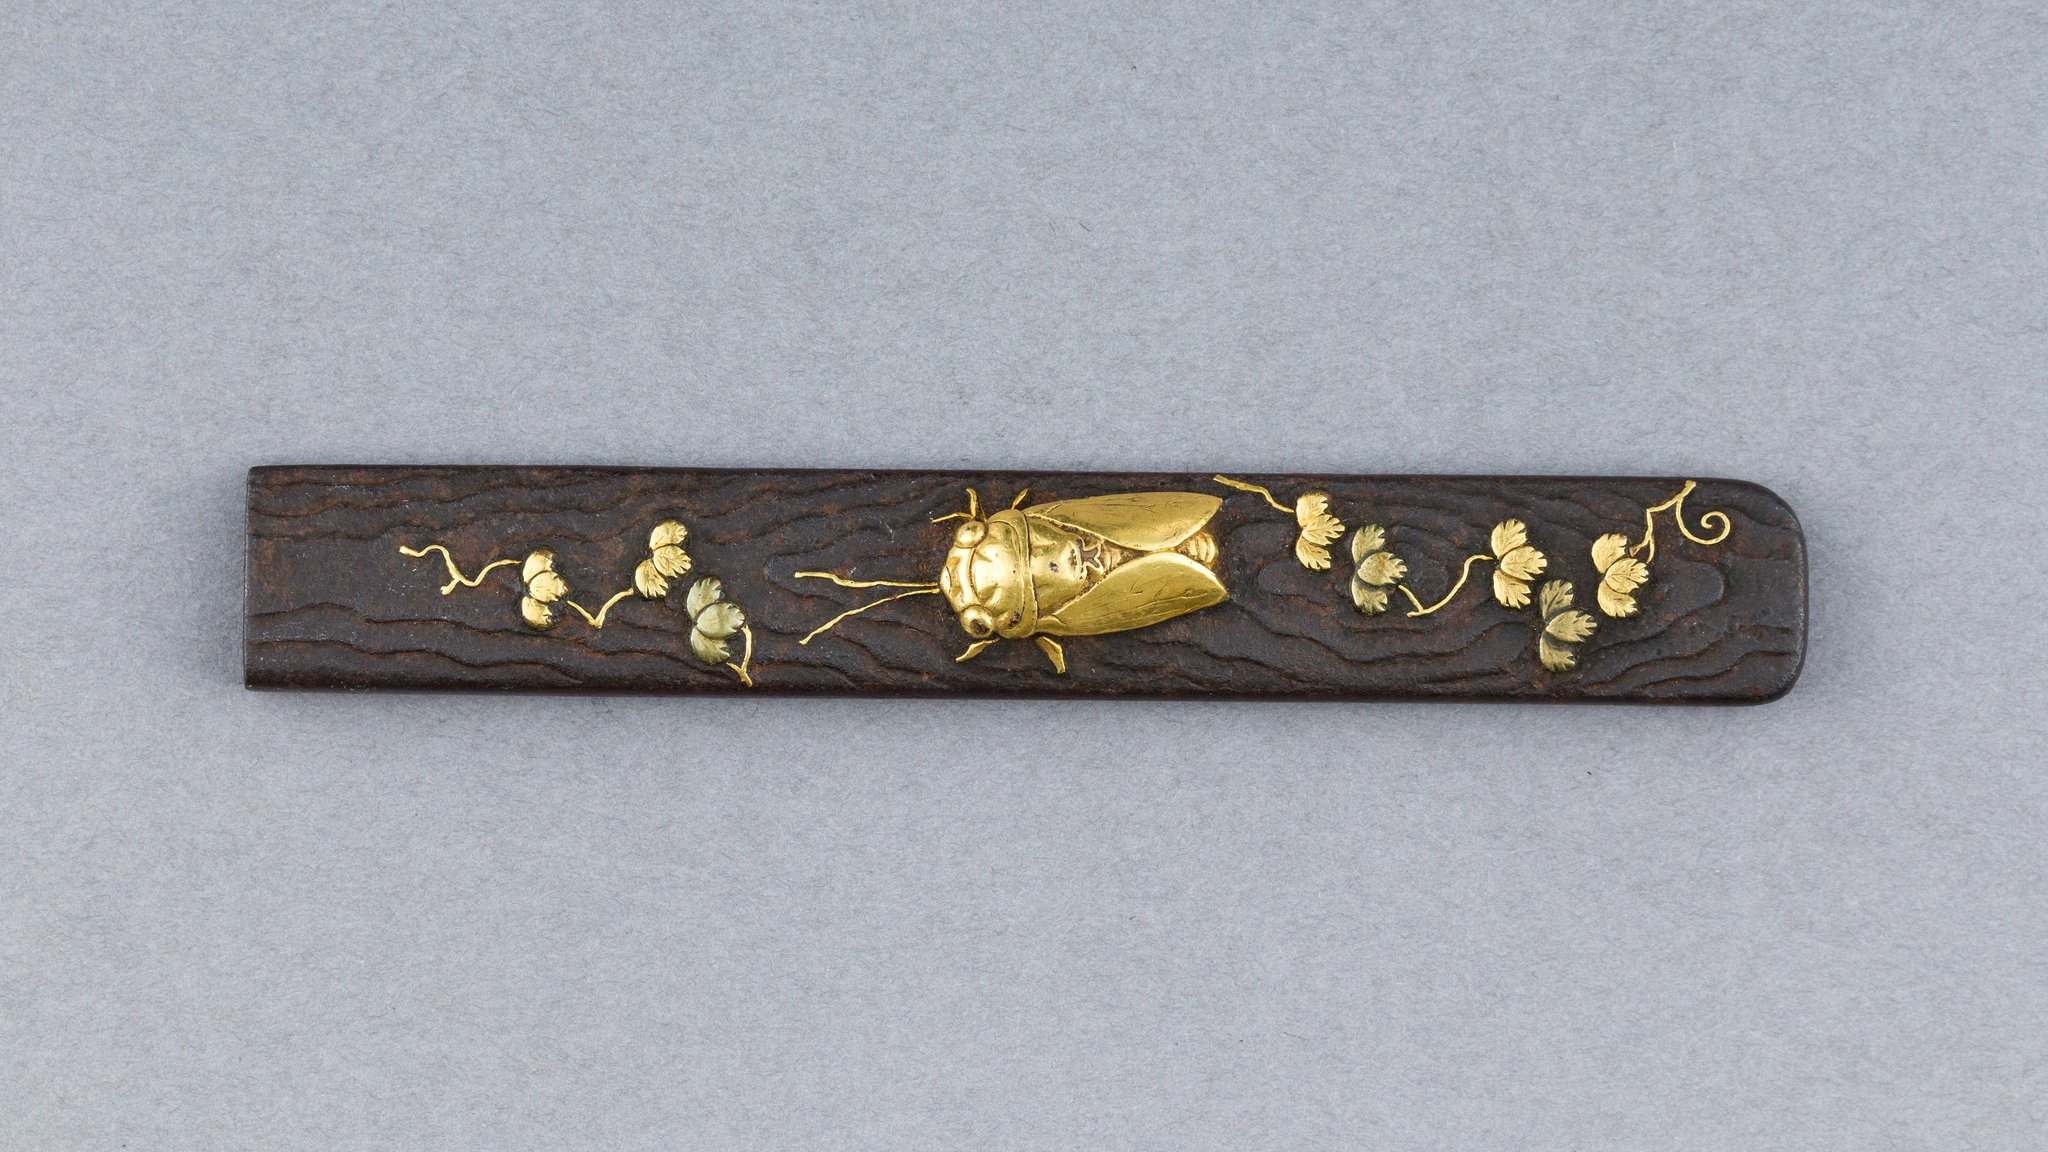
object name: knife handle kozuka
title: Knife Handle (Kozuka)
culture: japanese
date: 1615-1868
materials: gold, iron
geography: japan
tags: insects